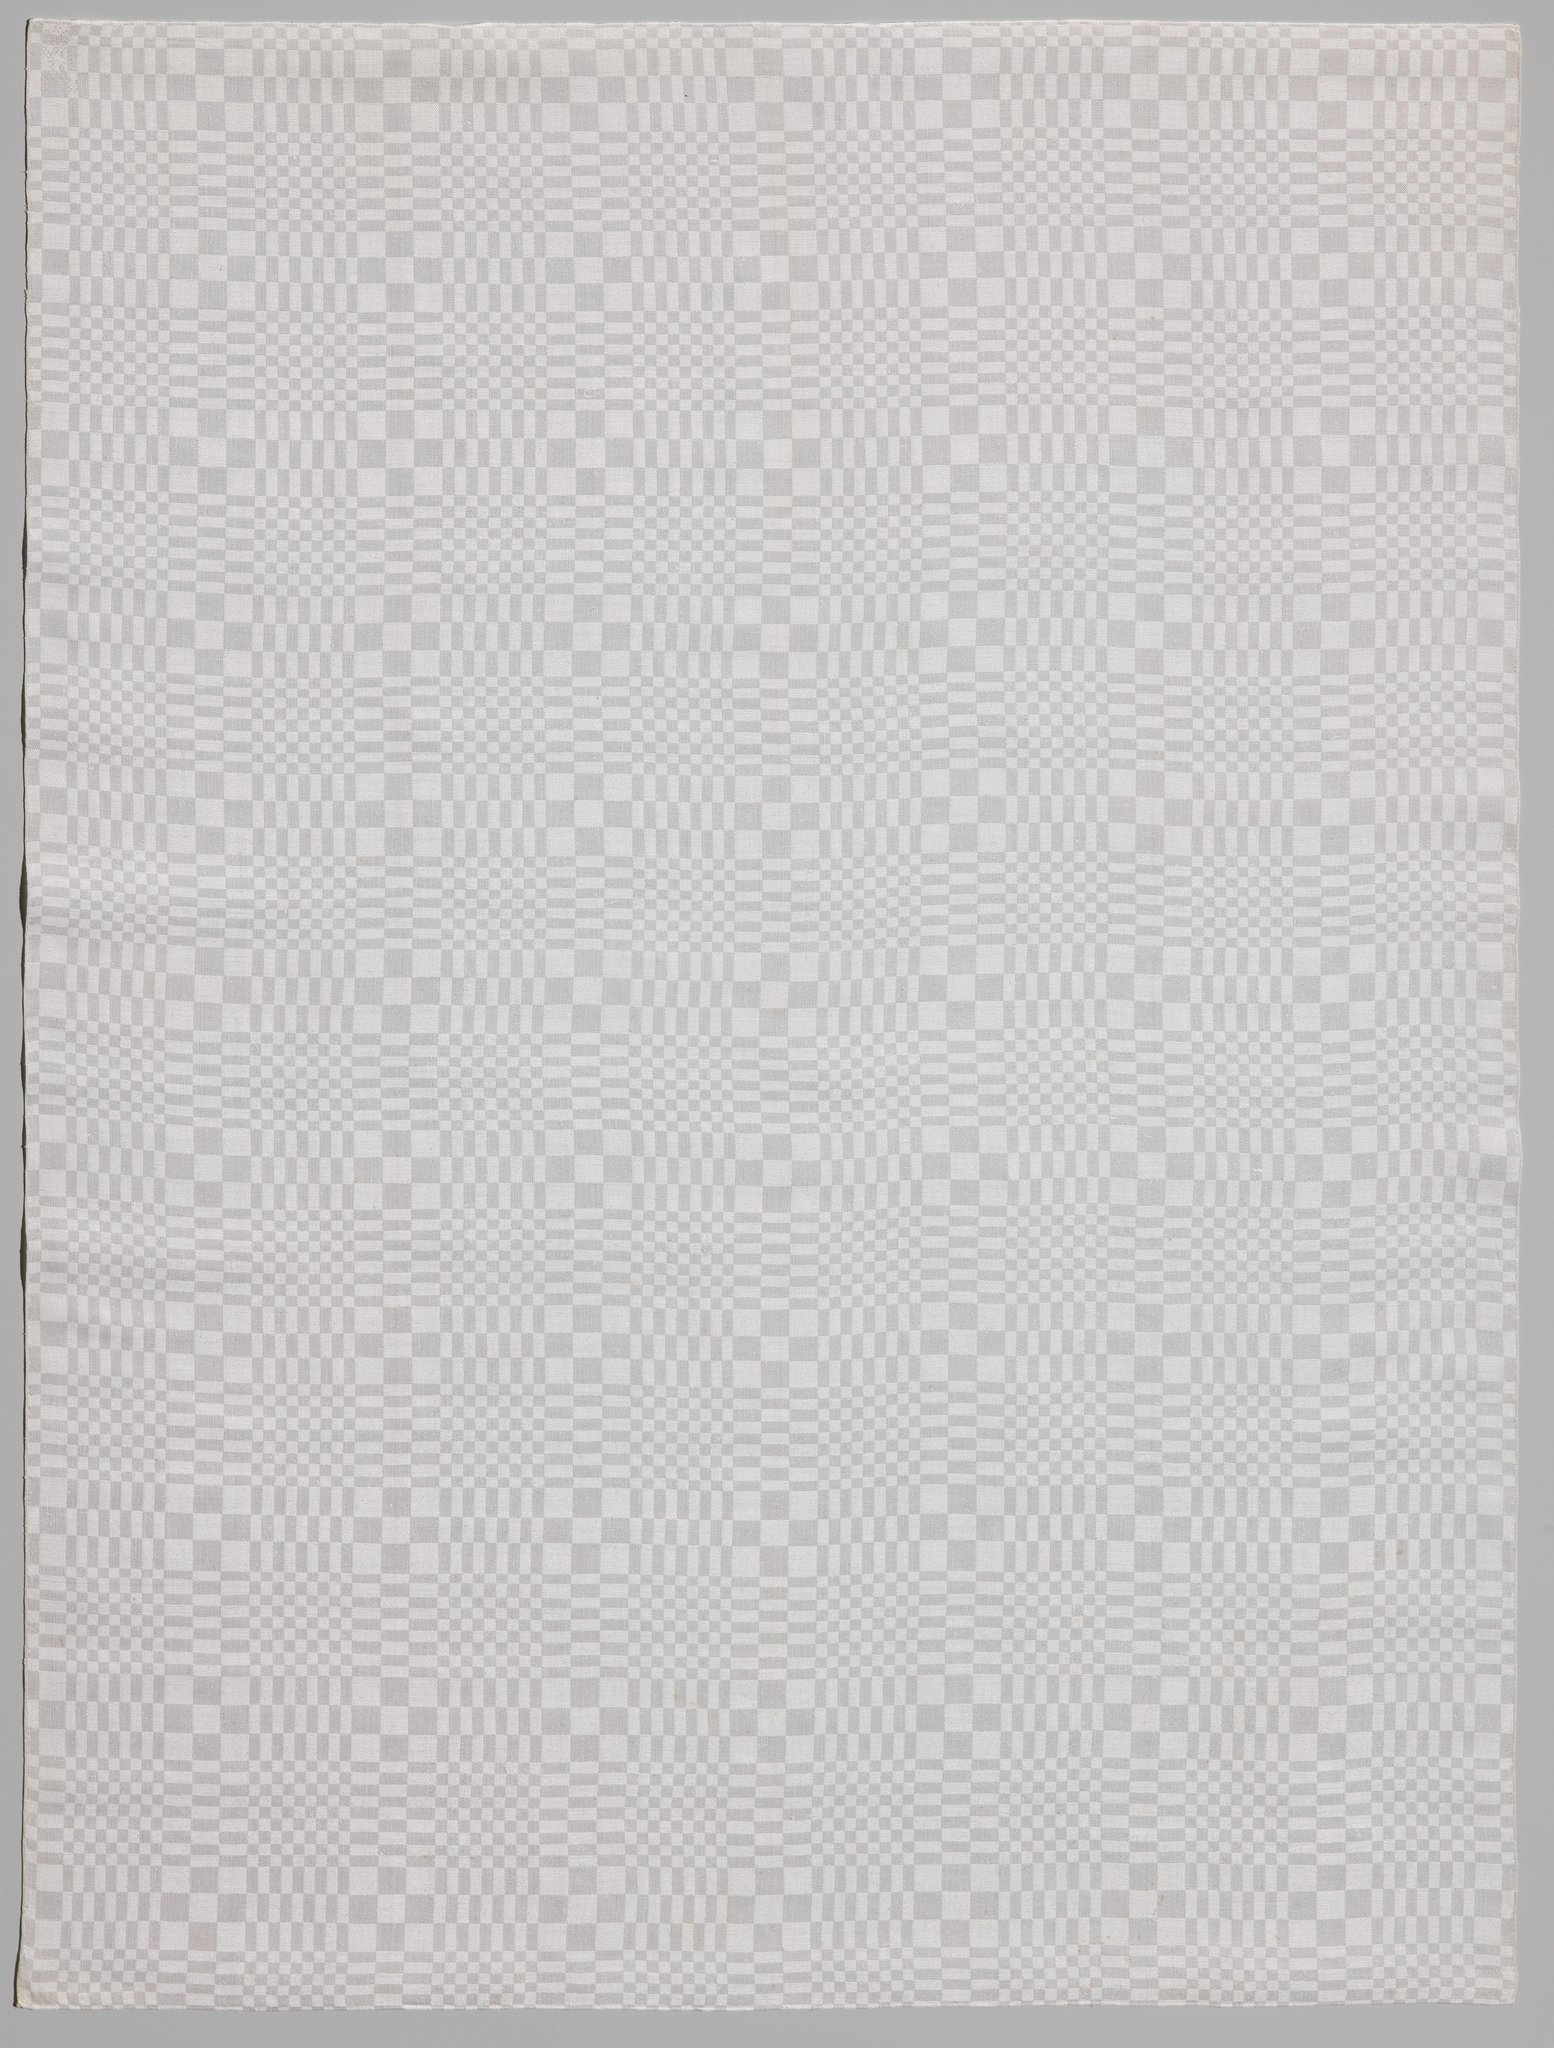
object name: napkin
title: Servet van pellendamast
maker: Anonymous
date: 1739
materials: linen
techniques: weave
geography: northern netherlands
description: Wit linnen servet met pellenpatroon, genaamd "Engelse garderobe". Merk kroon WG 36 1739.